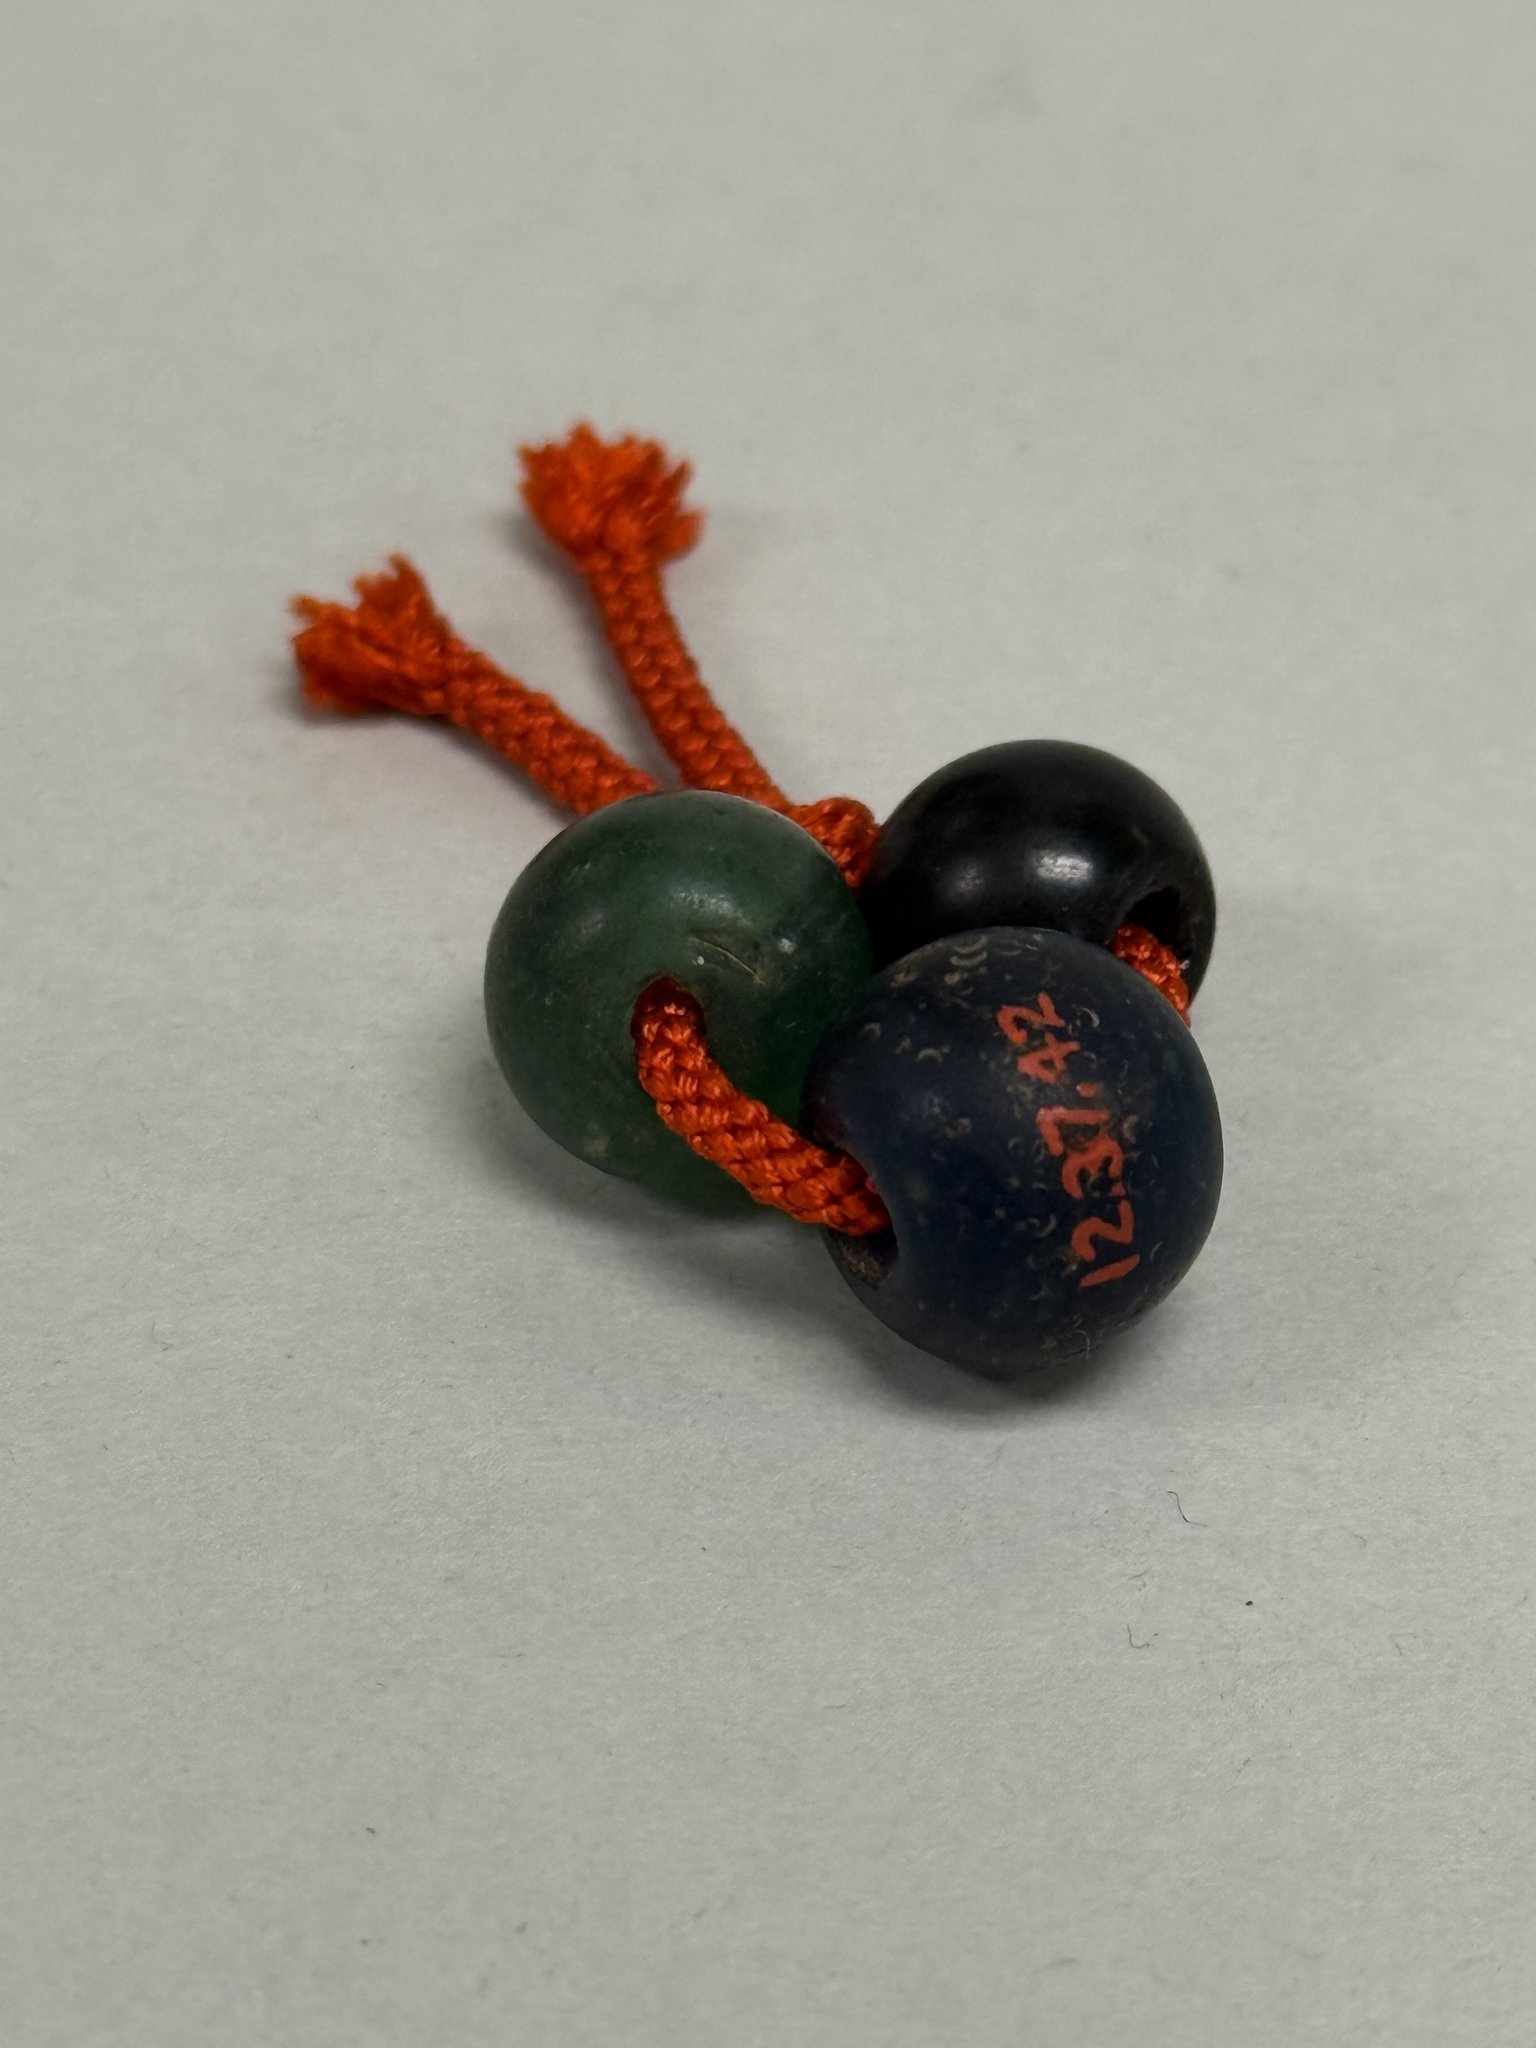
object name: bead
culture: japanese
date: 601-700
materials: glass, lacquer